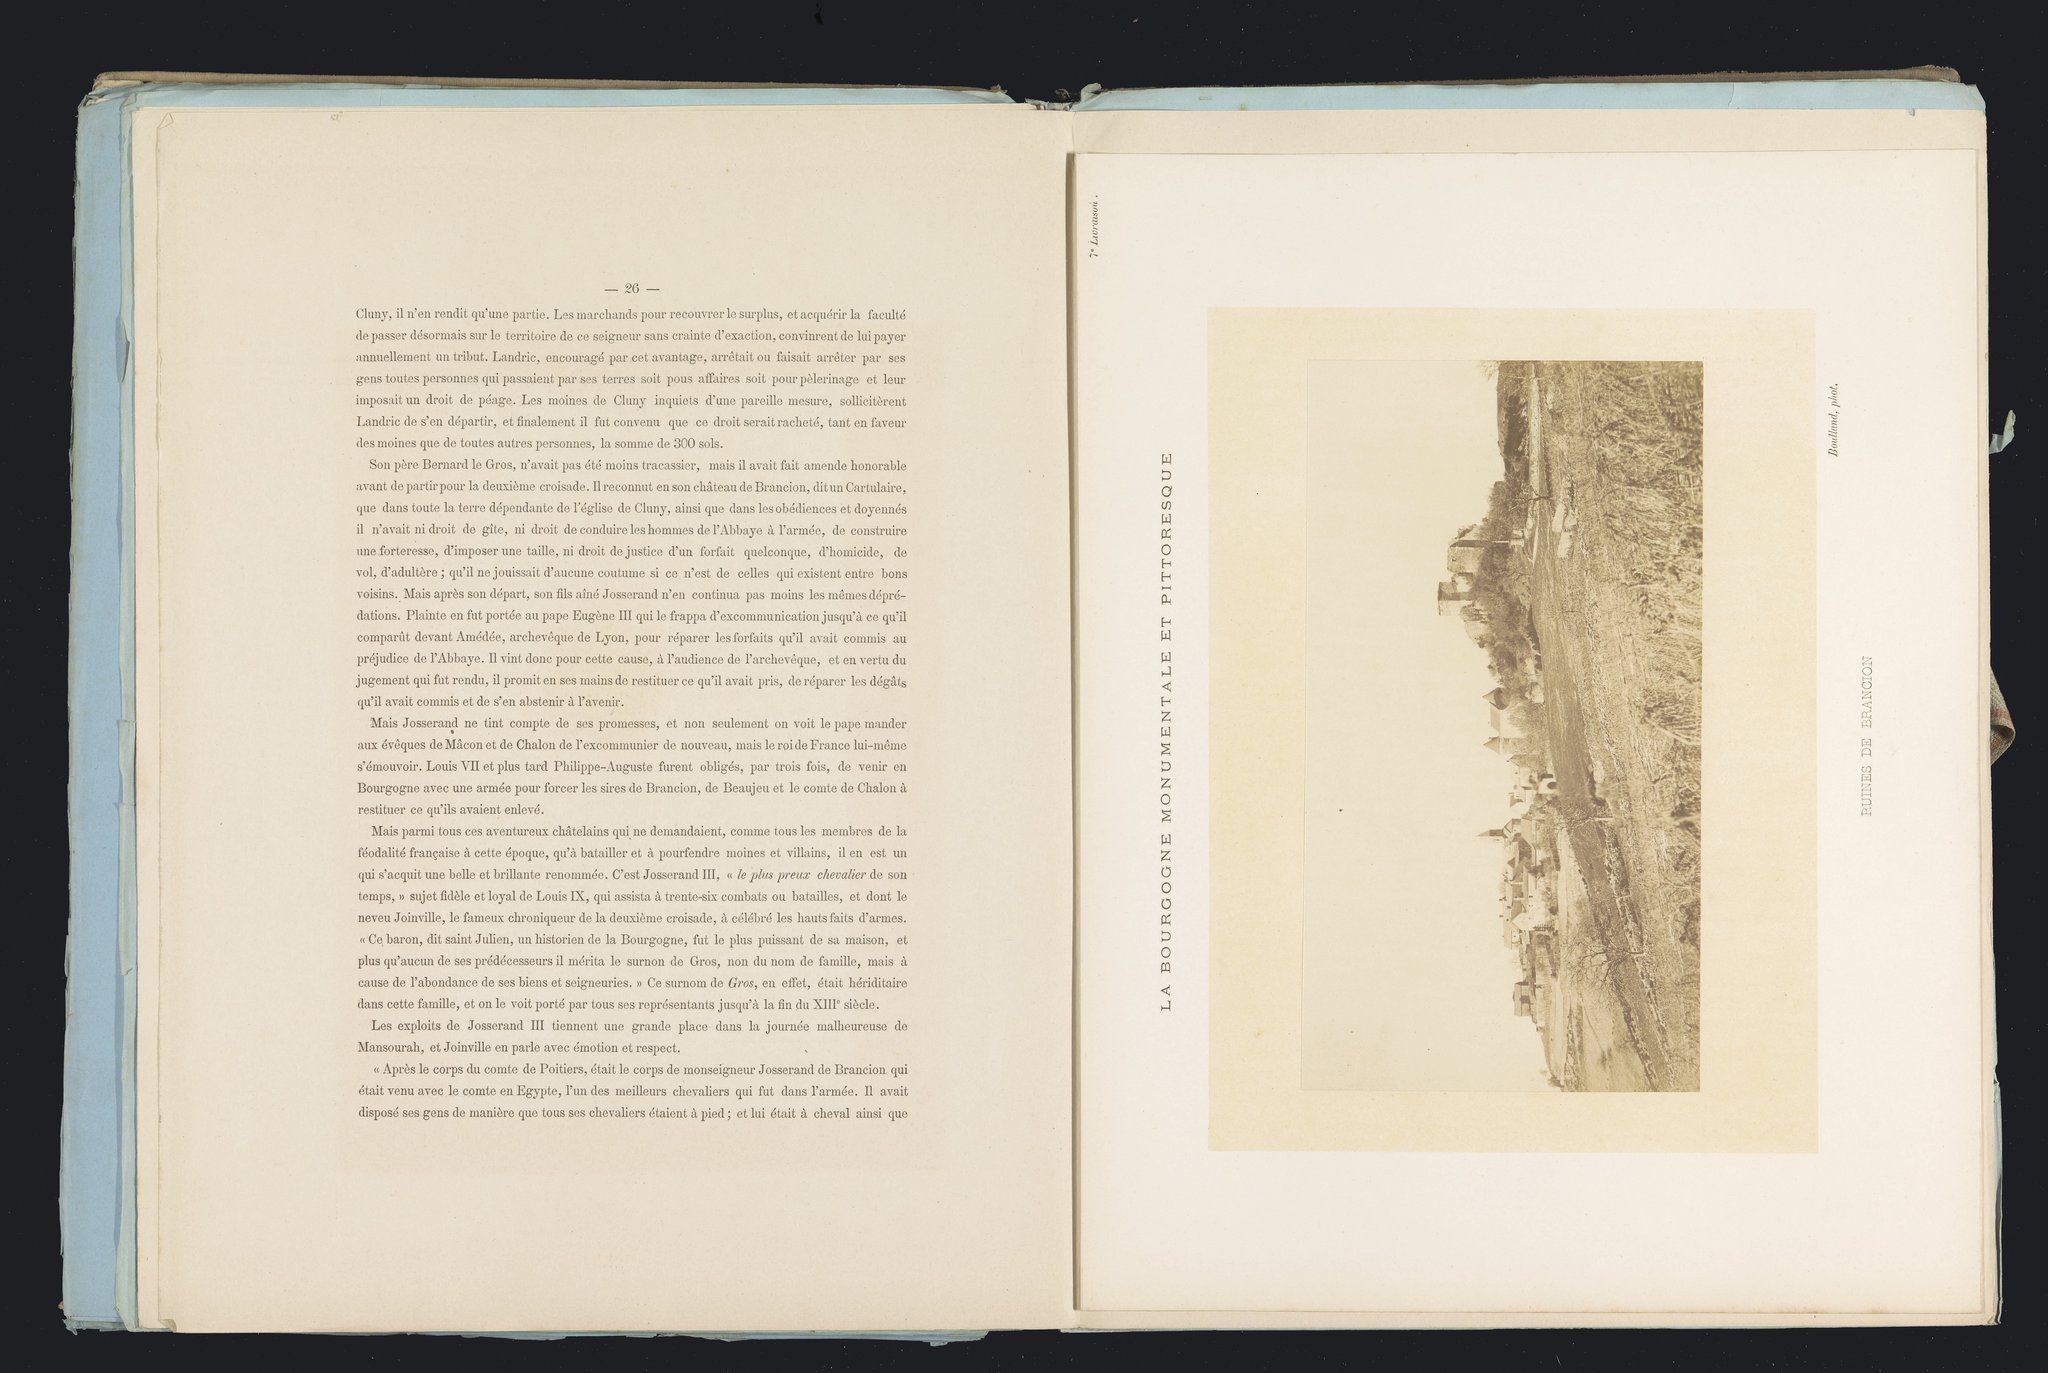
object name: photograph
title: Gezicht op Brancion met rechts de kasteelruïne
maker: alfred boulland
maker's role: fotograaf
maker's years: 1814-1887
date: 1850-1873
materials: cardboard, photographic support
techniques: albumen print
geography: martailly-lès-brancion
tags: prospect of village, silhouette of village, castle